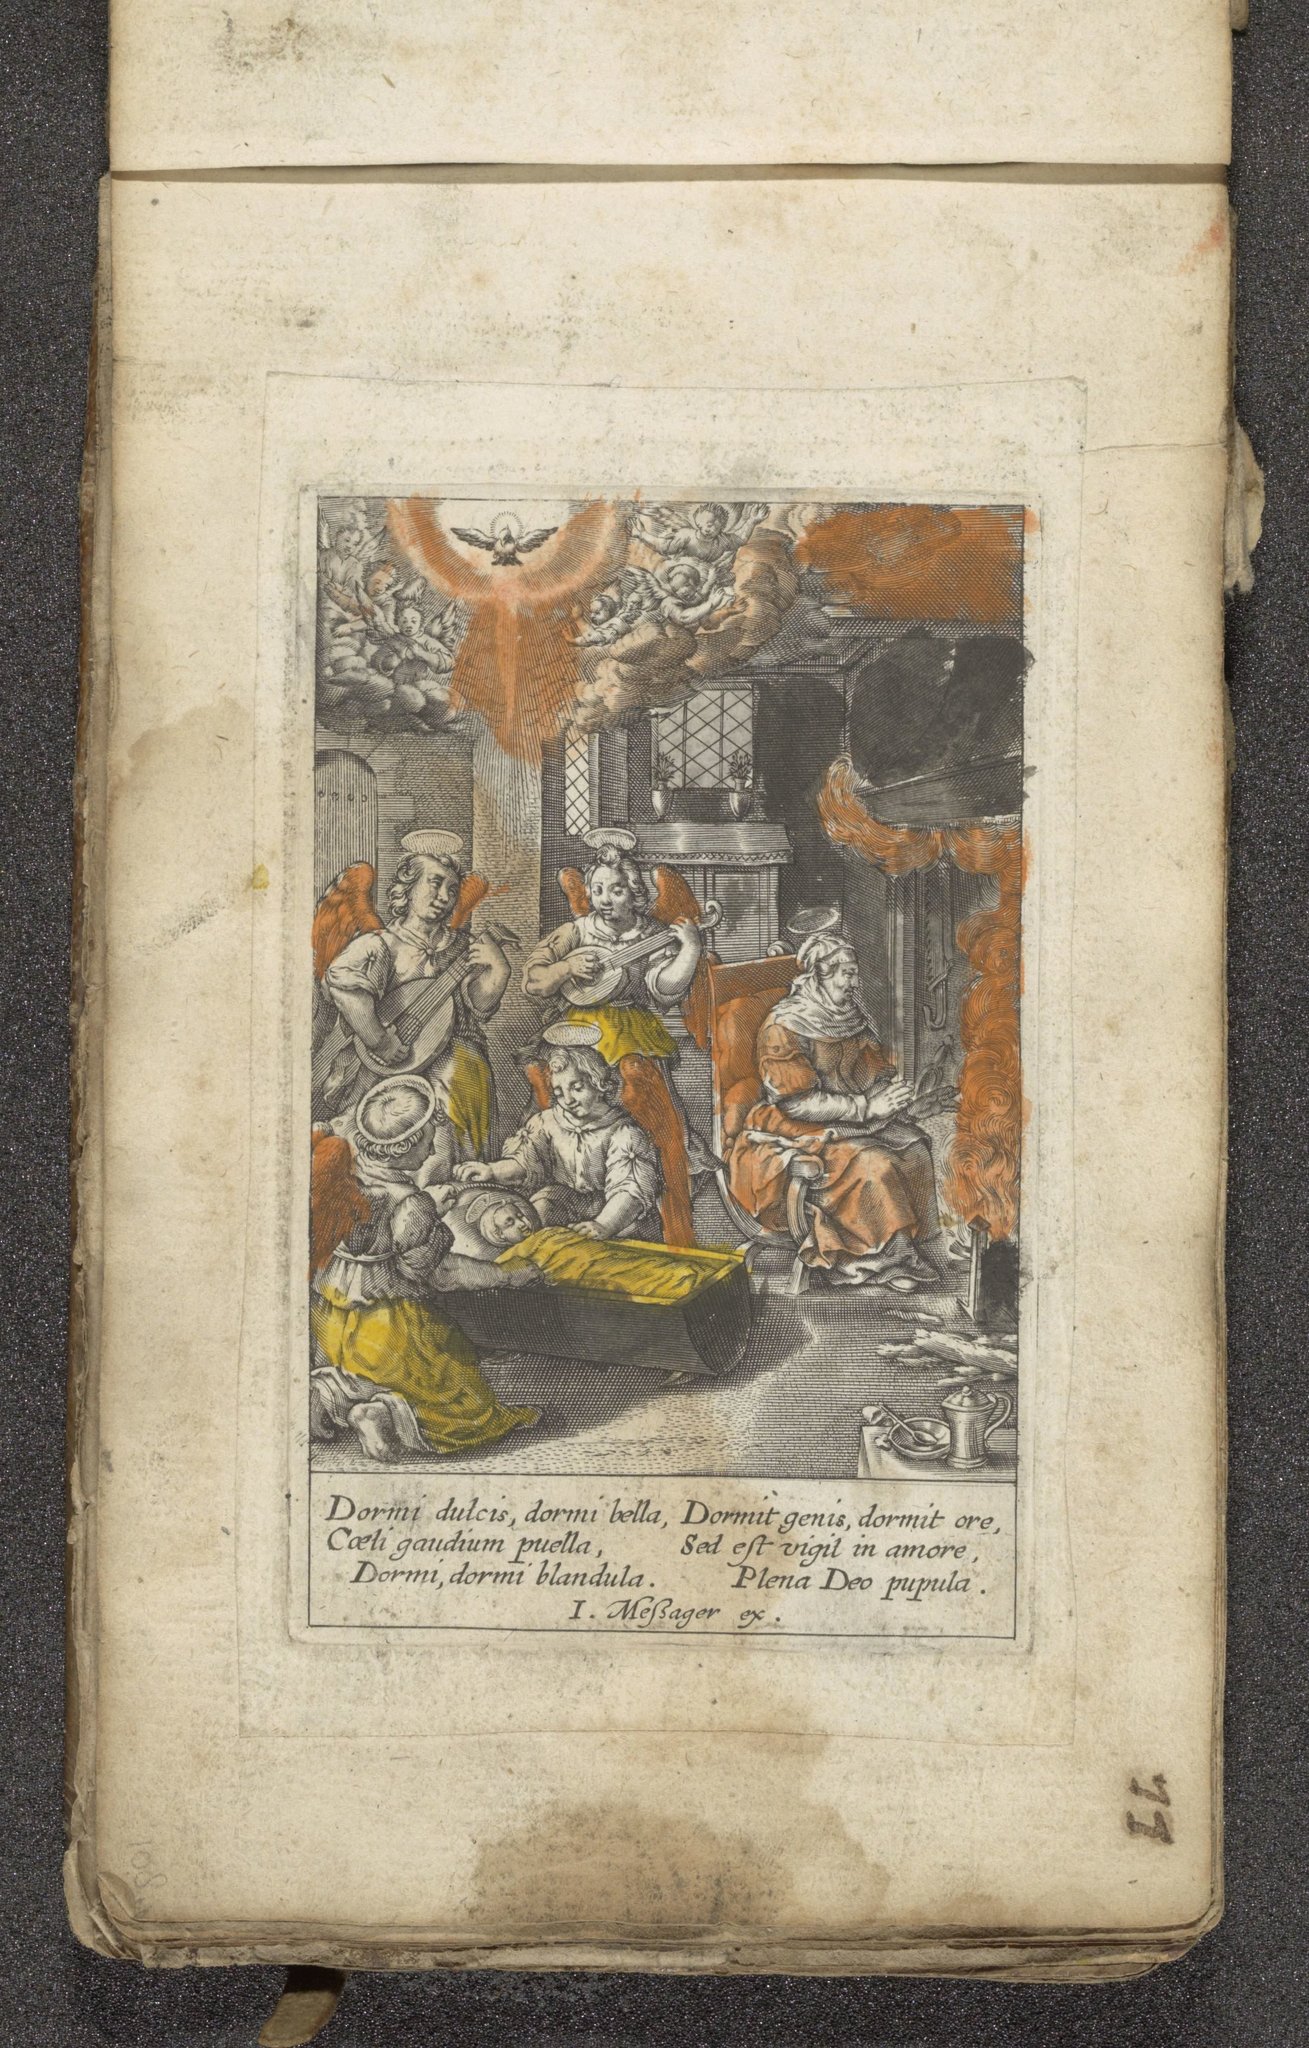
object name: print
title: Maria slaapt in haar wieg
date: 1590-1649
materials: paper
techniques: colour, engraving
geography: paris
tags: (joachim and anna with) the baby mary (+ angel(s)), sleeping; unconsciousness, open fire, fire-place, stove (in kitchen), holy ghost represented as a dove (in flames) (+ angel(s))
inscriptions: inscription: ‘77’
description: De jonge Maria ligt in haar wieg. Engelen musiceren en zingen haar in slaap. Boven het wiegje de Heilige Geest als duif, te midden van engelenkoren. Bij de openhaard is haar moeder Anna haar handen aan het warmen. In de marge een zesregelig onderschrift, in twee kolommen, in het Latijn. De prent maakt deel uit van een album.